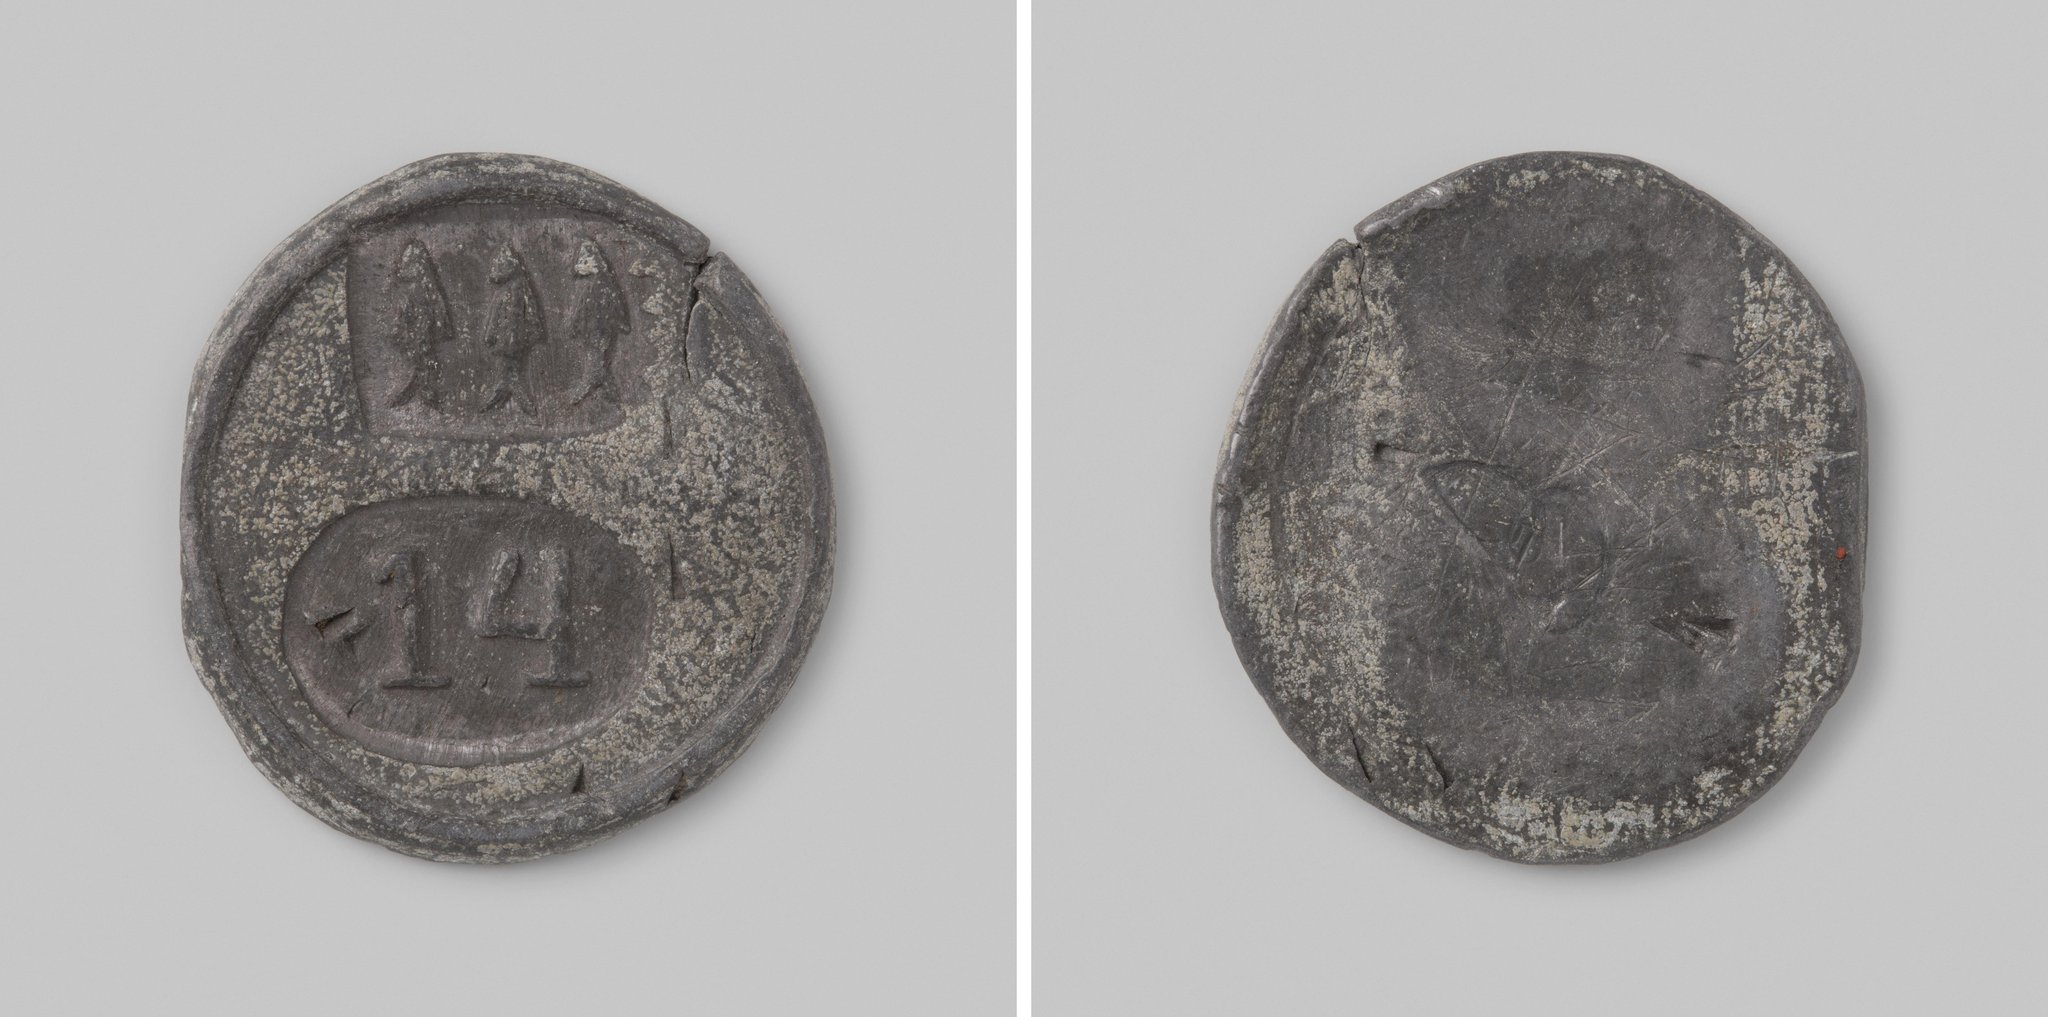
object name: tax token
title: Bakenlood (lantaarnlood) uit Enkhuizen, 1914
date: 1914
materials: lead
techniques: printing, casting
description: Rond gegoten plaatje lood met een schildvormige instempeling van het wapen van Enkhuizen en een ovalen instempeling 14, de achterkant blanco